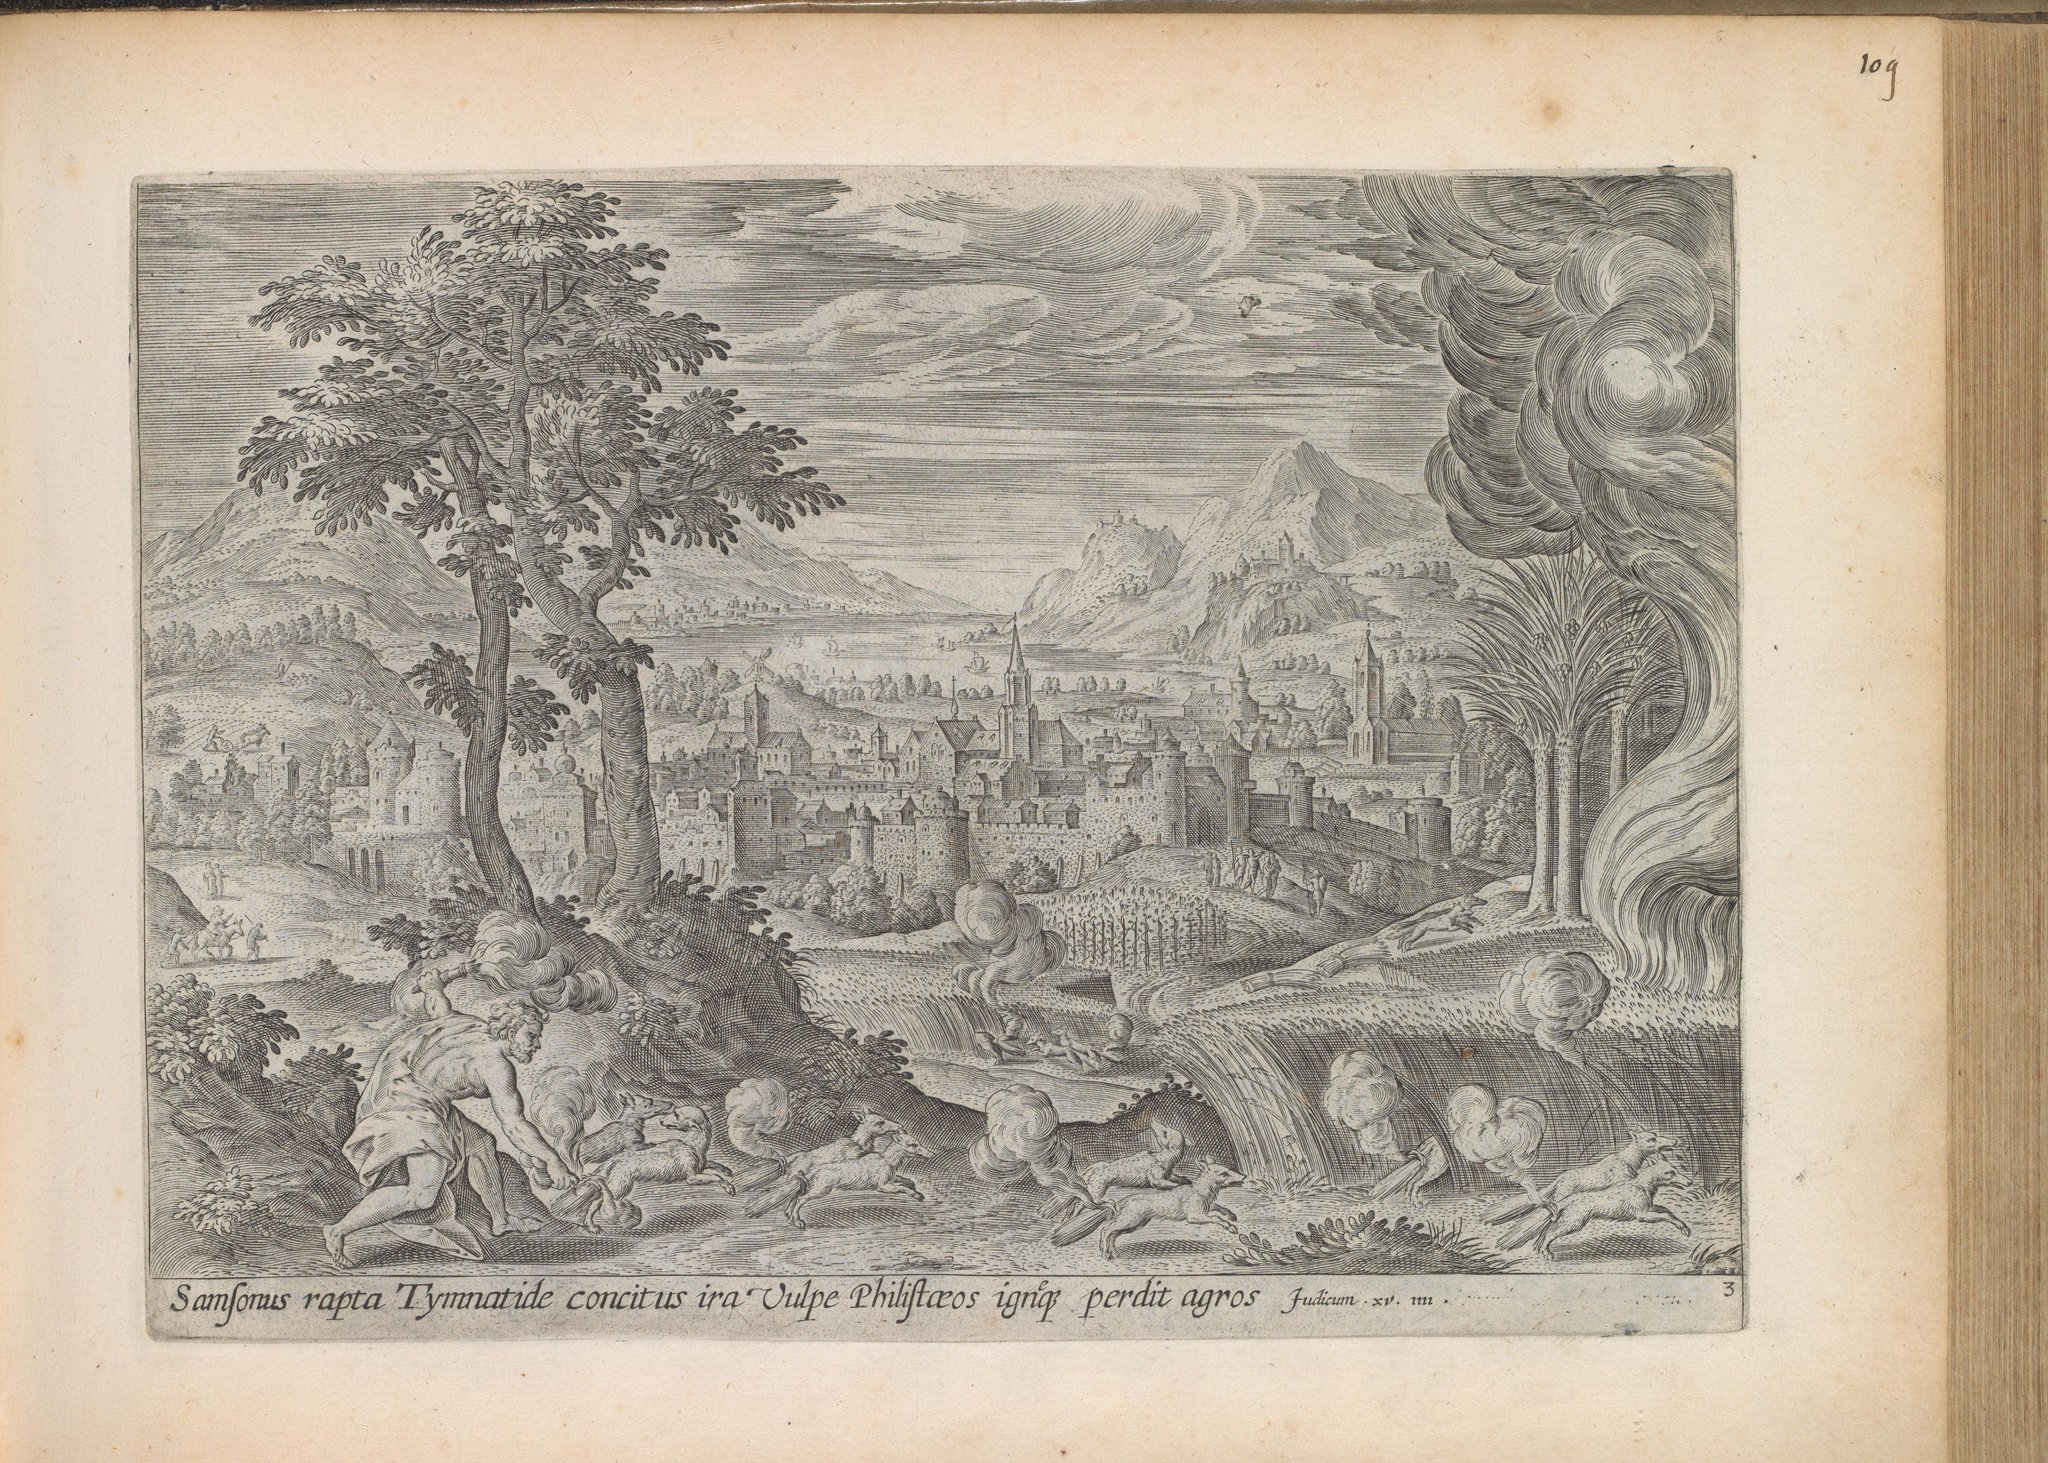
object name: album leaf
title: Geschiedenis van Simson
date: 1579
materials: paper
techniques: engraving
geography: amsterdam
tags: samson ties three hundred foxes two by two by their tails with a fire-brand in between; with the torches on fire he lets them go into the cornfields of the philistines which are set aflame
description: Simson steekt de korenvelden van de Filistijnen in brand door vossen twee aan twee met de staarten aan elkaar te binden en een brandende fakkel ertussen te hangen. Simson stuurt de vossen het korenveld in. Onder de voorstelling een verwijzing in het Latijn naar de Bijbeltekst in Ri. 15:4. Deze prent maakt deel uit van een album.